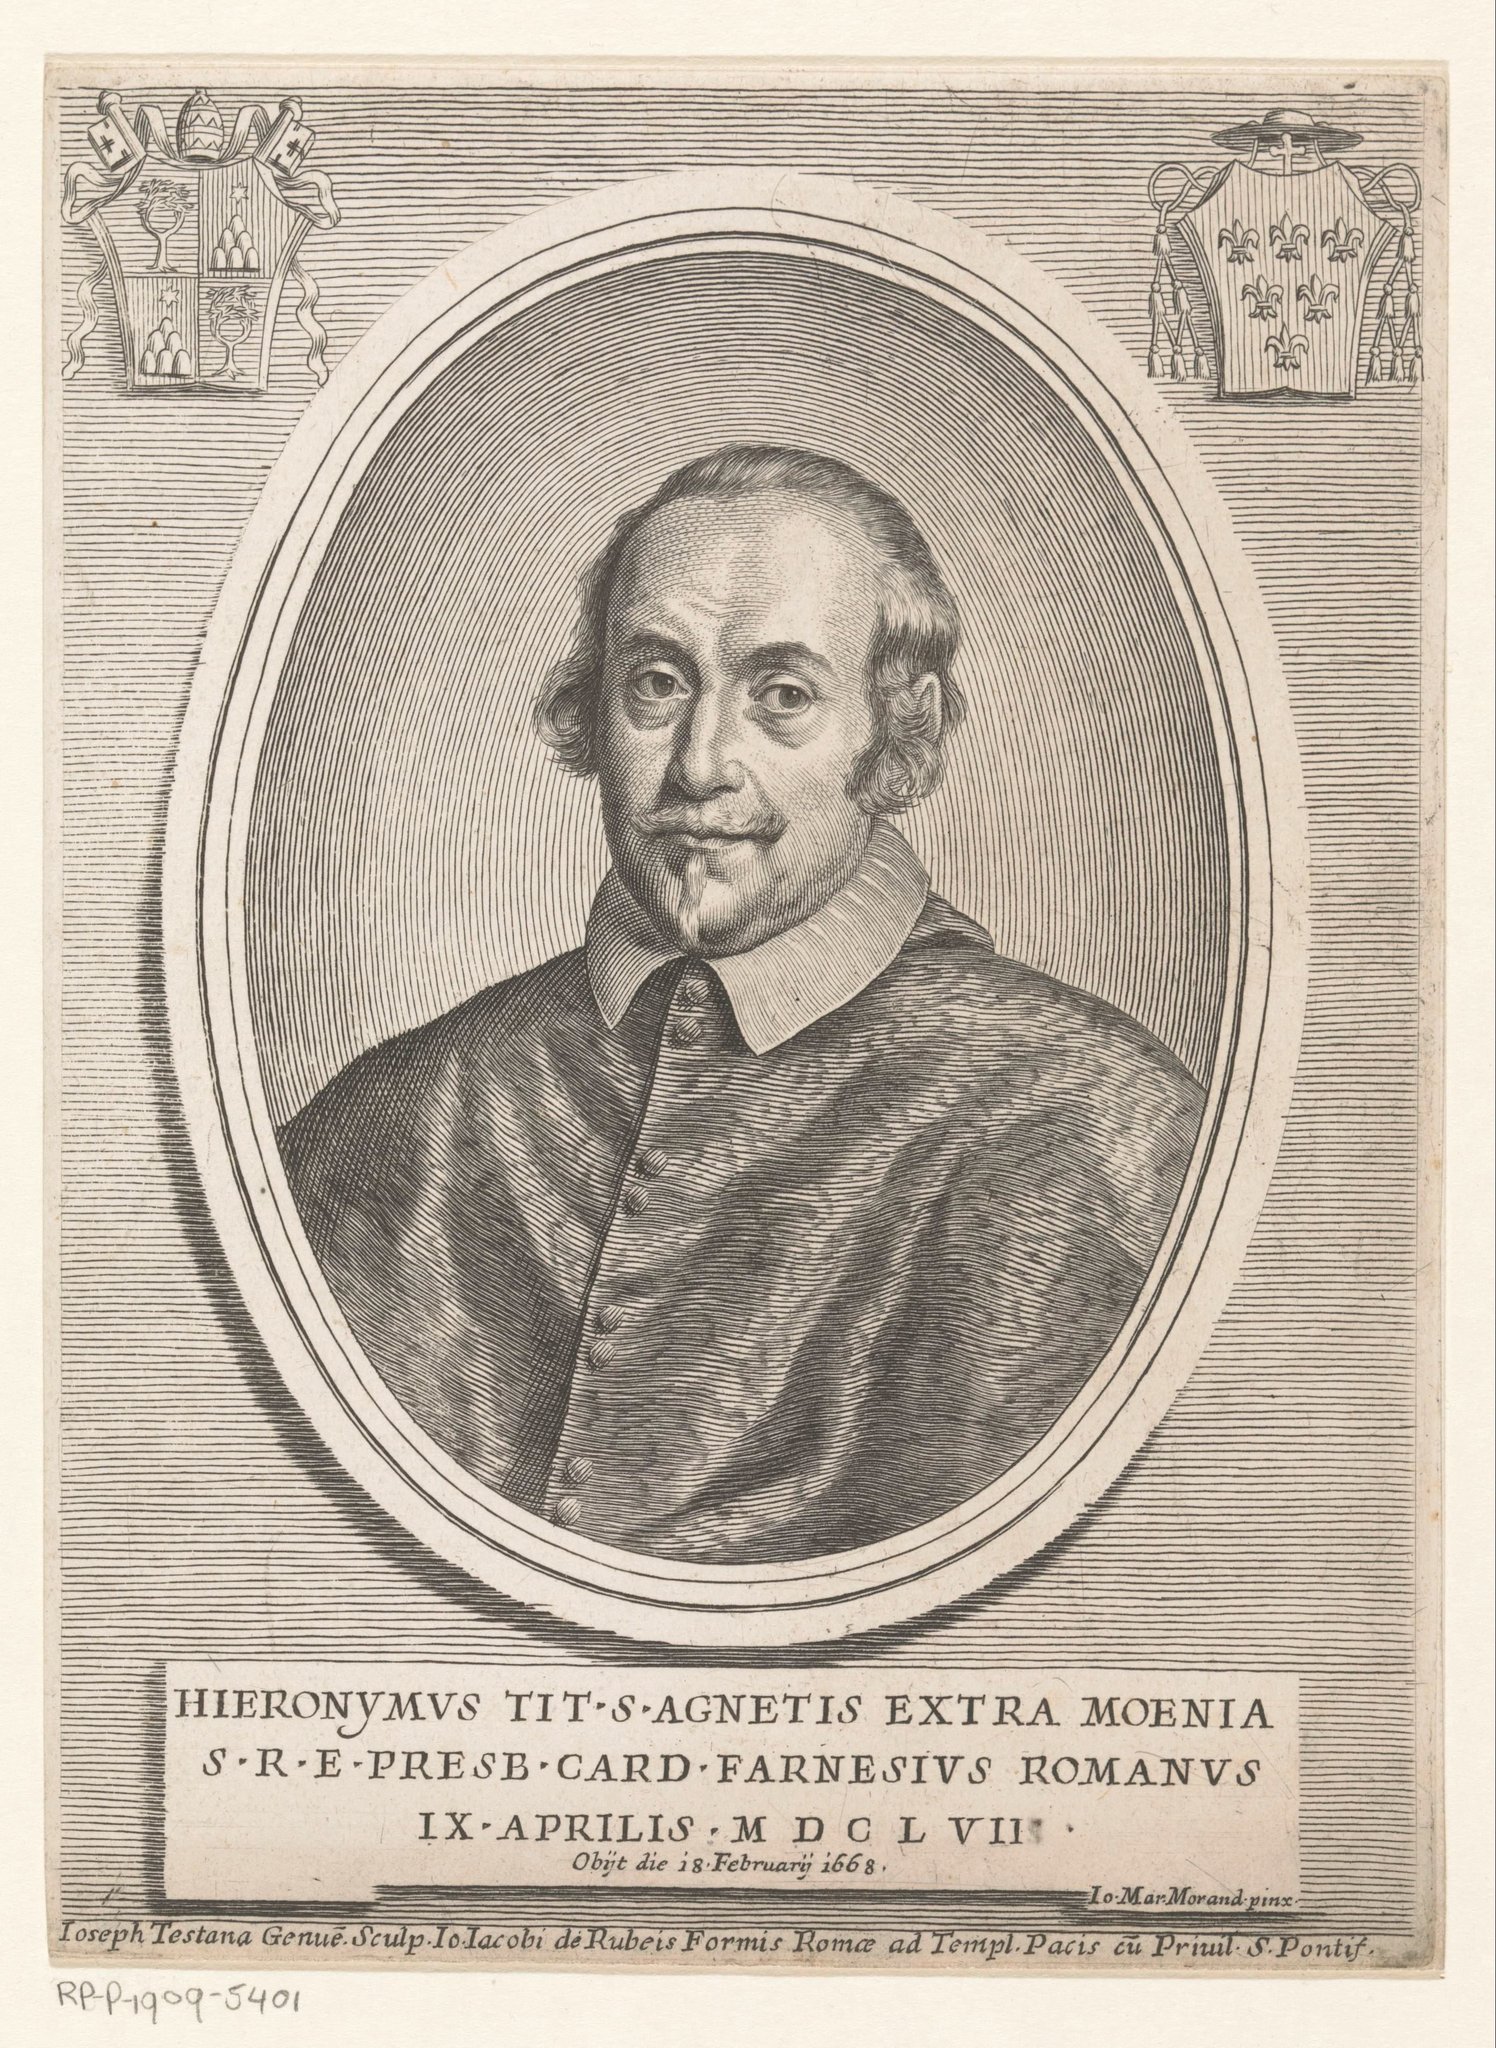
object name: print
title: Portret van kardinaal Girolamo Farnese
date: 1658-1679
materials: paper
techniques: engraving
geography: italy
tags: rome, cardinal, historical persons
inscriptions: collector's mark: Lugt 2228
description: Prent uit een reeks van onbekende omvang met portretten van kardinalen. De prenten werden vanaf 1657 vervaardigd in opdracht van uitgever Giovanni Giacomo de’ Rossi, waarna de productie werd voortgezet onder leiding van zijn opvolgers Domenico de’ Rossi en Lorenzo Filippo de’ Rossi, en ten slotte onder leiding van de Calcographia R.C.A.